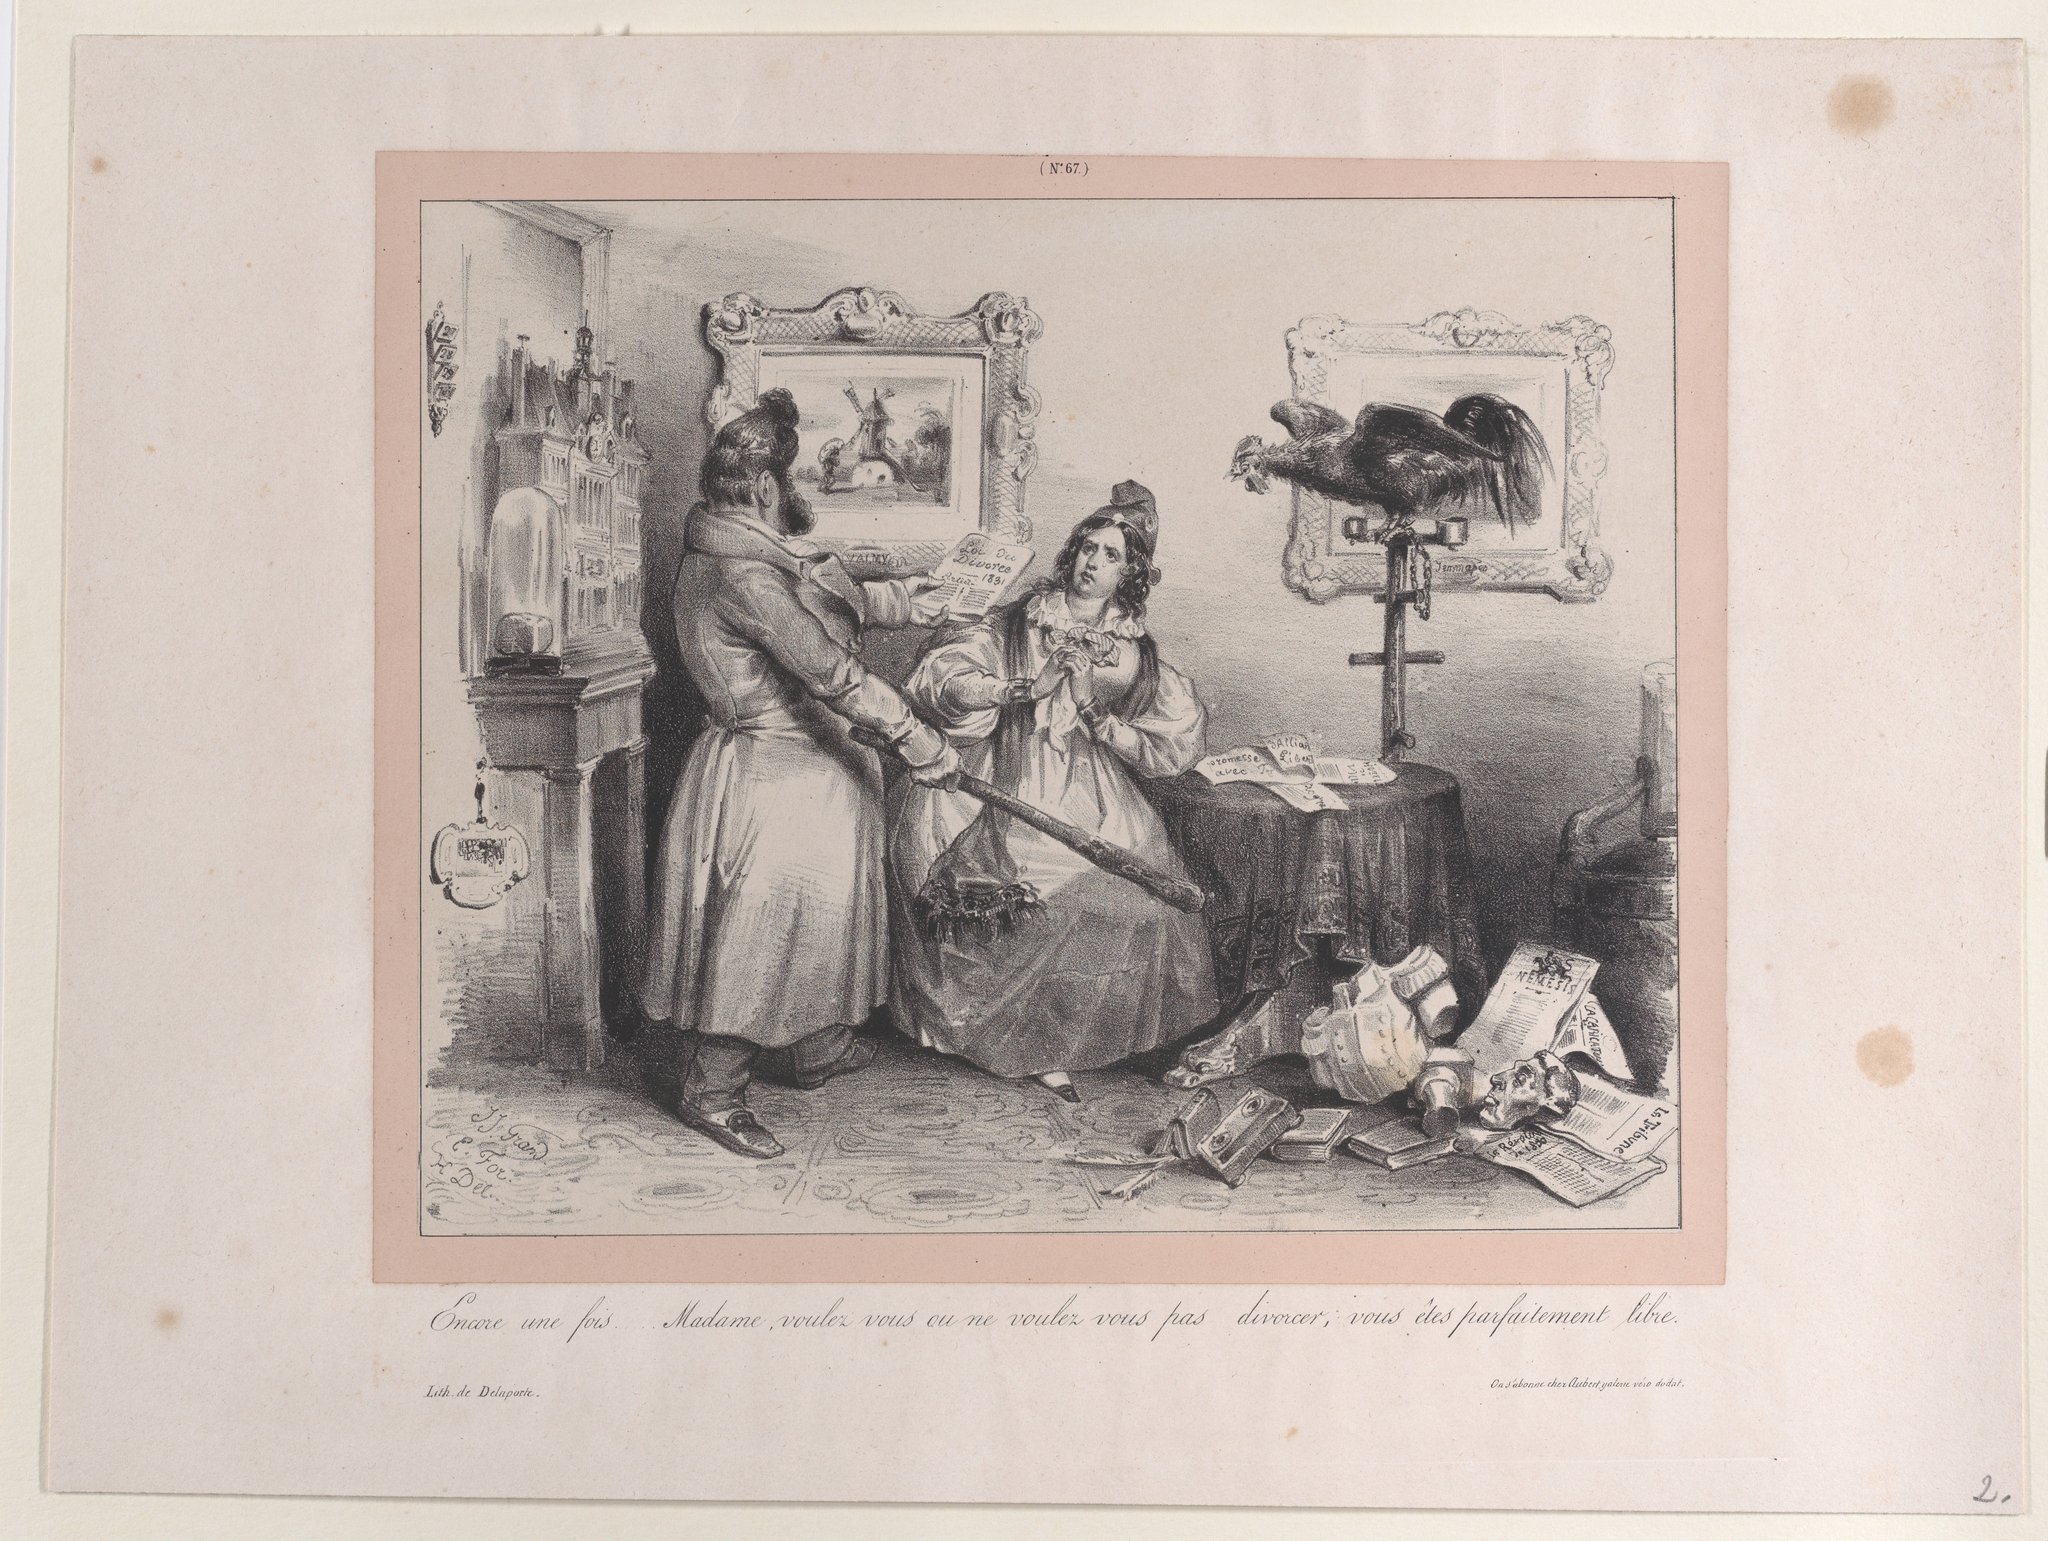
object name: print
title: "Again, Madame, whether you do or do not want to divorce, you are perfectly free"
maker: j. j. grandville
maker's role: artist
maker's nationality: french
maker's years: 1803-1847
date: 1832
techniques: lithograph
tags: men,women,roosters